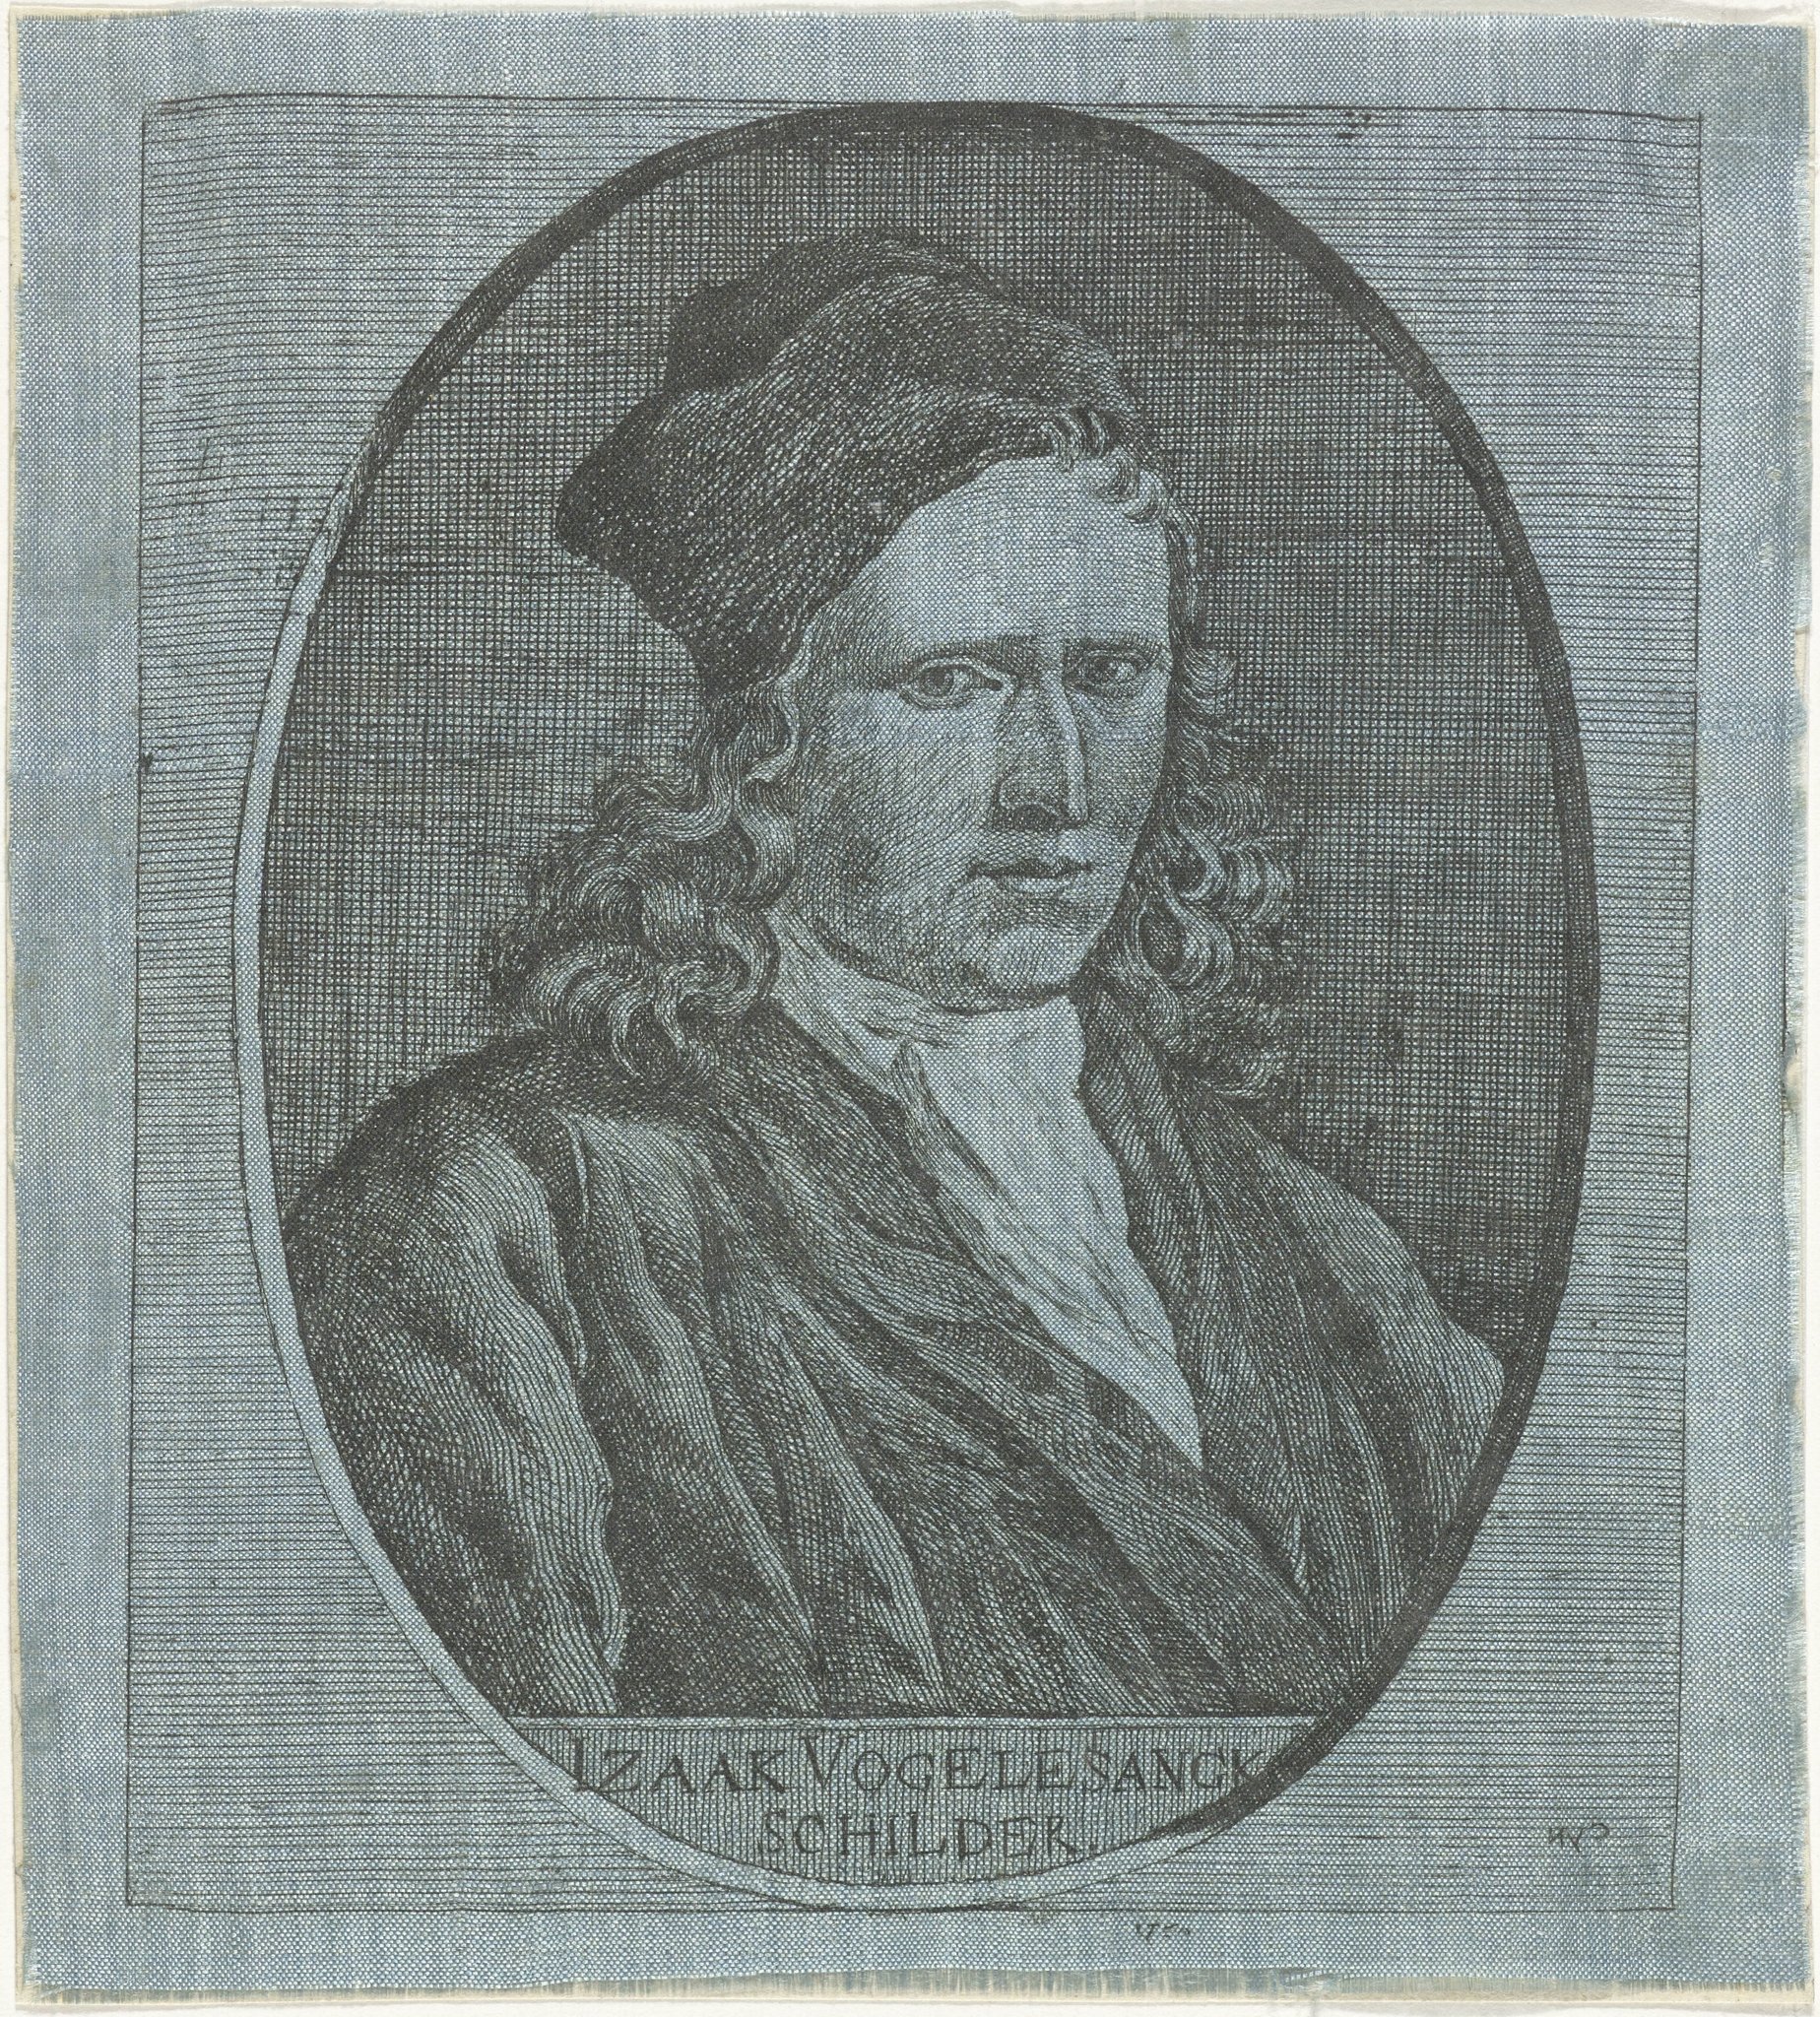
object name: print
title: Portret van Izaak Vogelensanck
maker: cornelis van noorde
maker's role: draughtsman, print maker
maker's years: 1731-1795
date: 1750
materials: silk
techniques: etching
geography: haarlem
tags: amsterdam, london, painter, izaak vogelensanck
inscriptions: collector's mark: Lugt 2228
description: Portret van de schilder Izaak Vogelensanck.